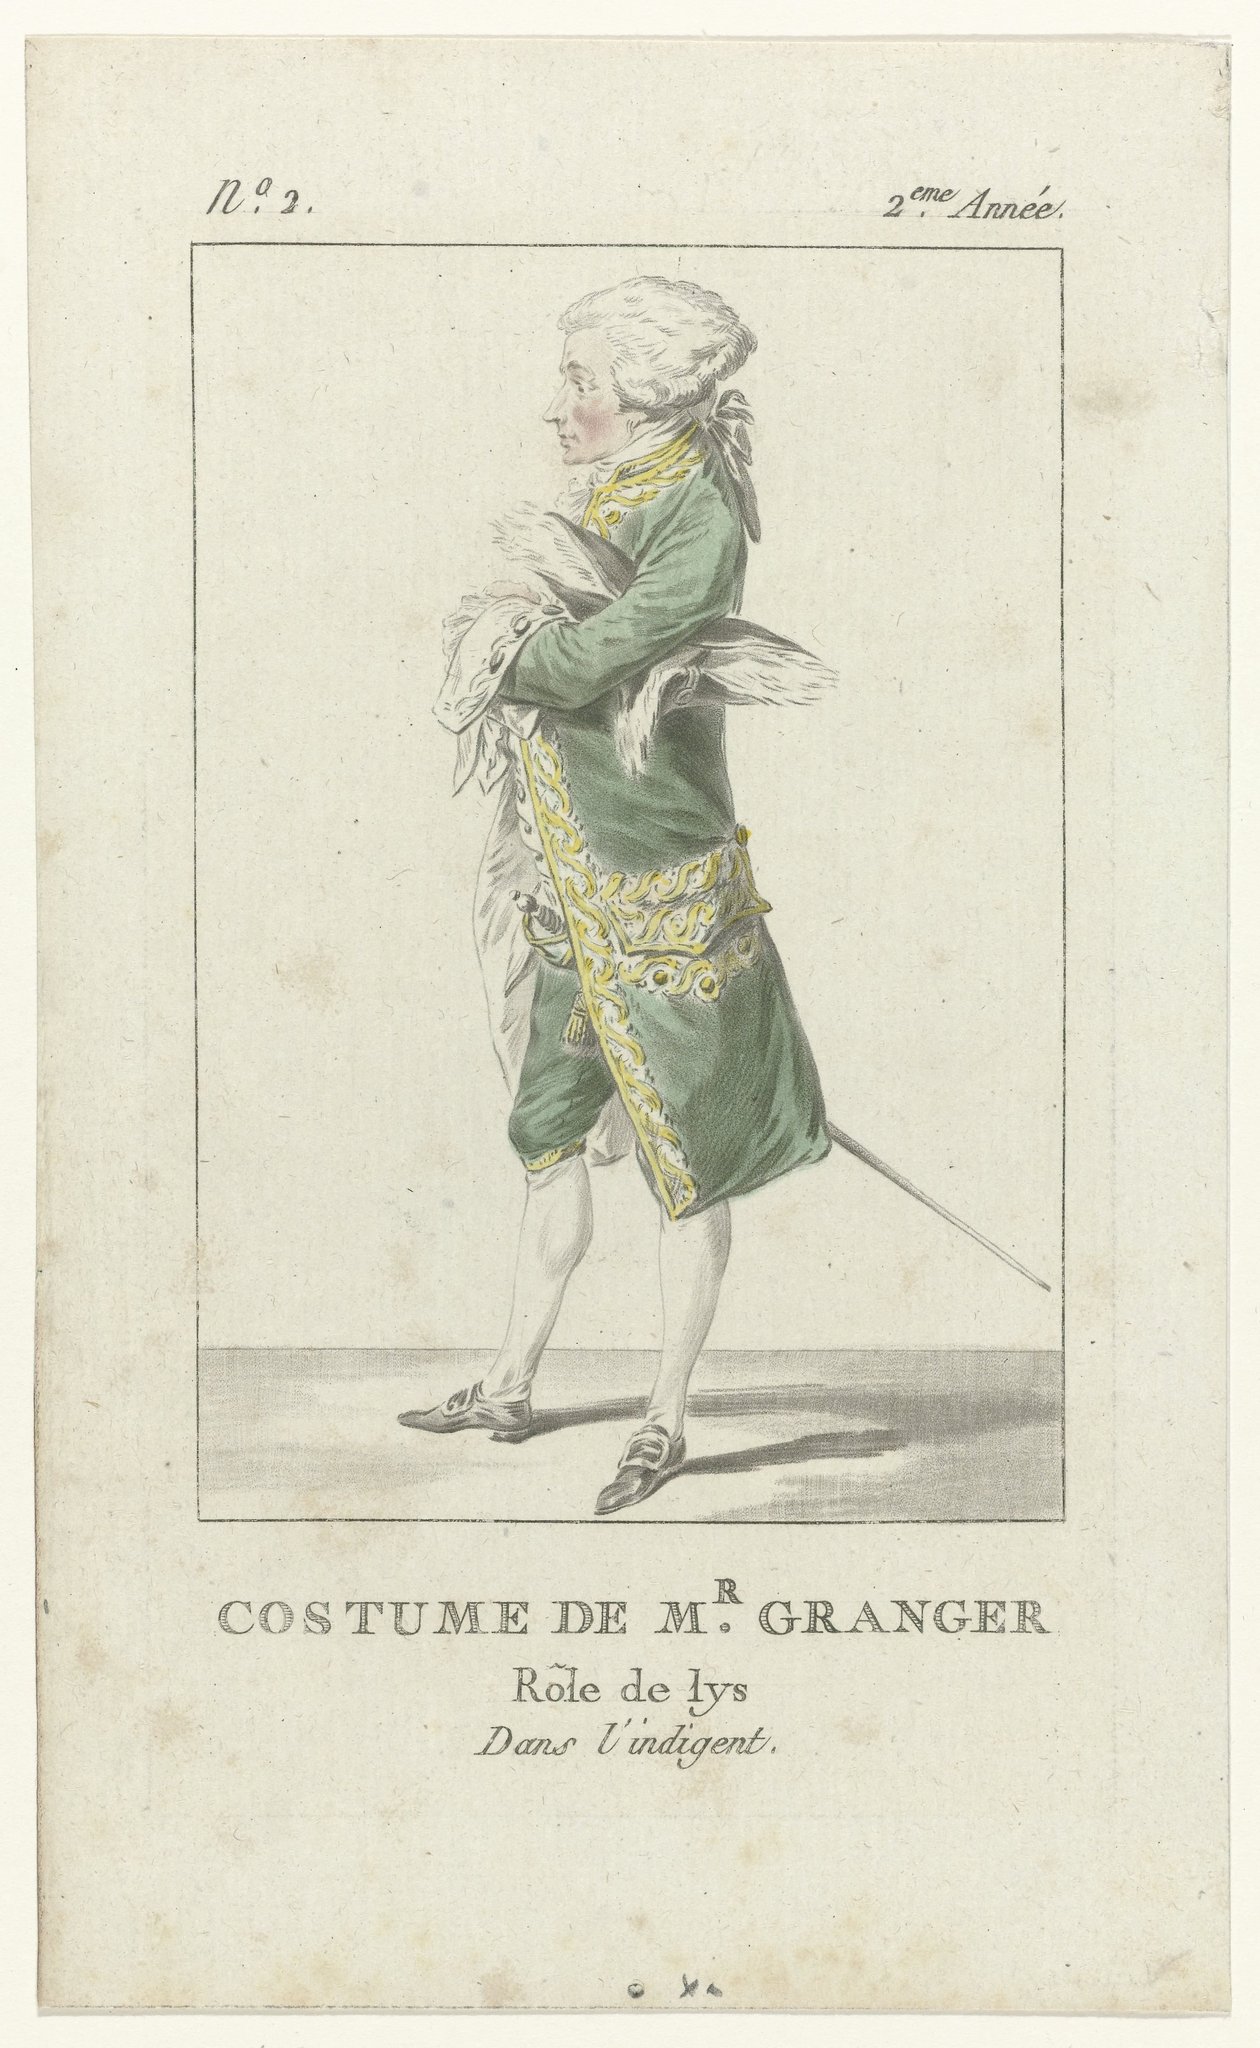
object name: costume print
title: Costume de Mr. Granger, No. 2, 2eme. Année : Role de lys (...)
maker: Anonymous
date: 1760-1800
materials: paper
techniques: hand coloring, lithograph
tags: head-gear: tricorn (+ men's clothes), ensembles of pieces of clothing (habit à la française) (+ men's clothes), coat (justaucorps) (+ men's clothes), fashion plates, shoes, sandals (+ men's clothes), clothes, costume (+ men's clothes), wig, trousers, breeches, etc. (breeches) (+ men's clothes), hacking and thrusting weapons: rapier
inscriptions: caption: ‘COSTUME DE M.R GRANGER / Rôle de lys / Dans l'indigent.’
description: Man in een 'habit à la française': jas, vest en kniebroek. Driekantige(?) steek onder de arm. Degen aan linkerzijde. Lage schoenen met vierkante gespen. Volgens het onderschrift is dit het kostuum van Mr Granger.